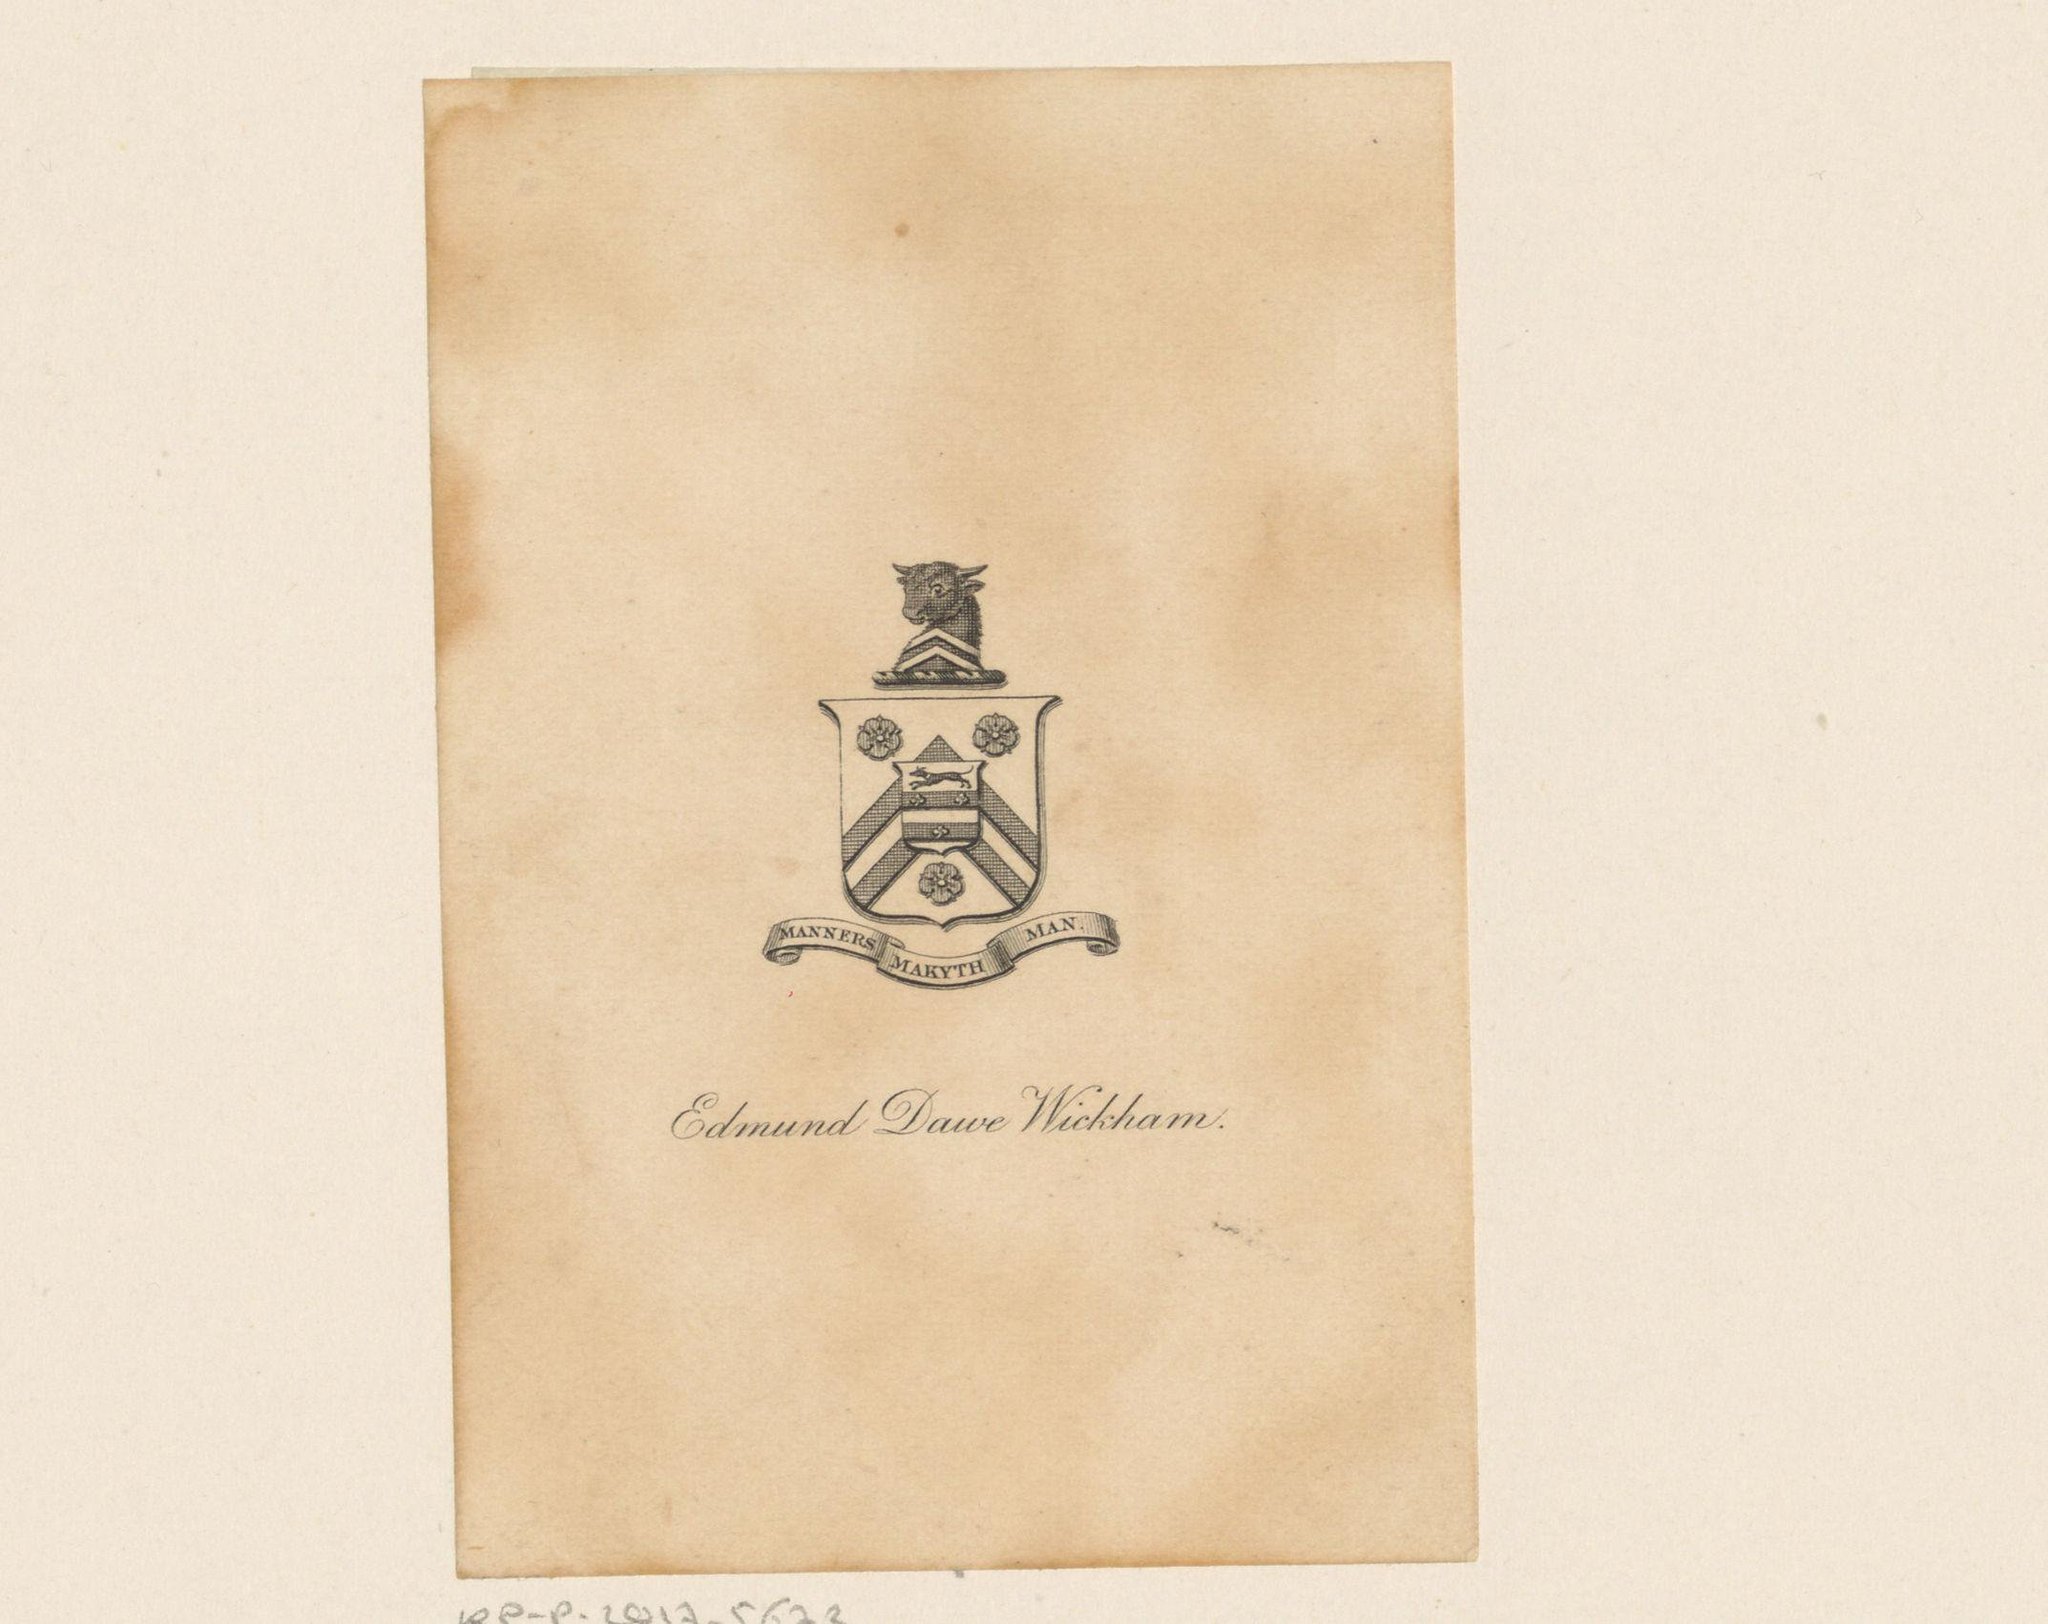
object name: bookplate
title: Ex libris van Edmund Dawe Wickham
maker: Anonymous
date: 1820-1894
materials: paper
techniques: etching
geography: england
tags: armorial bearing, heraldry